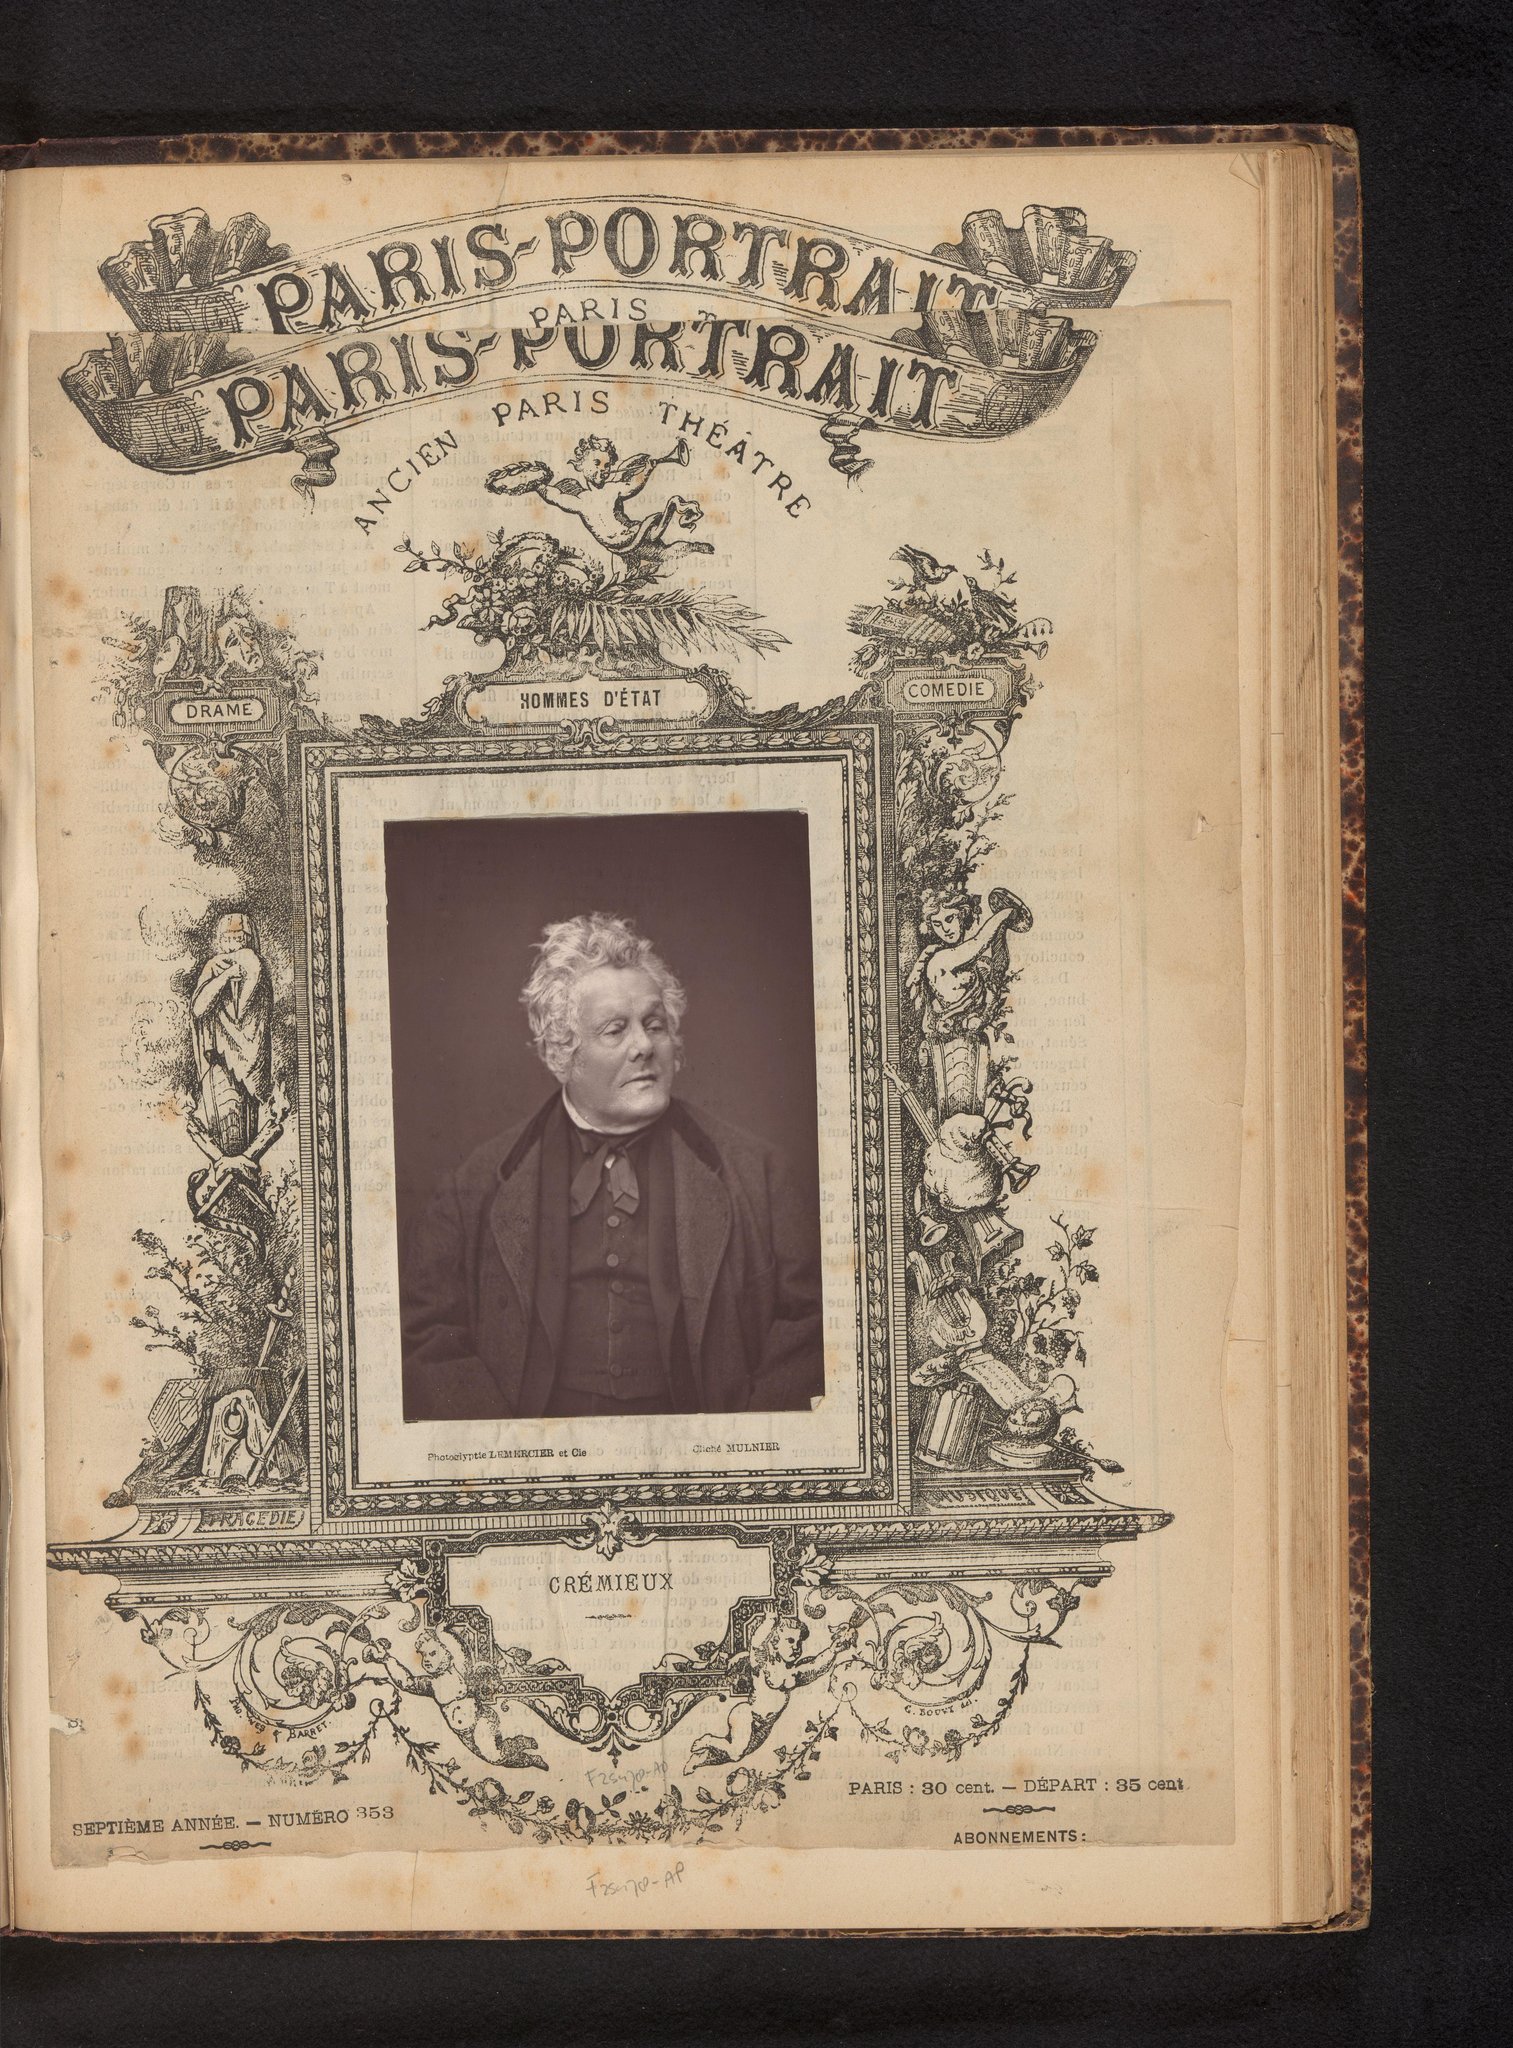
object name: photomechanical print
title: Crémieux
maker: ferdinand mulnier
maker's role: painter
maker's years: 1817-1891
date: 1873-1880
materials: paper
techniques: woodburytype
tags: paris, politician, historical persons